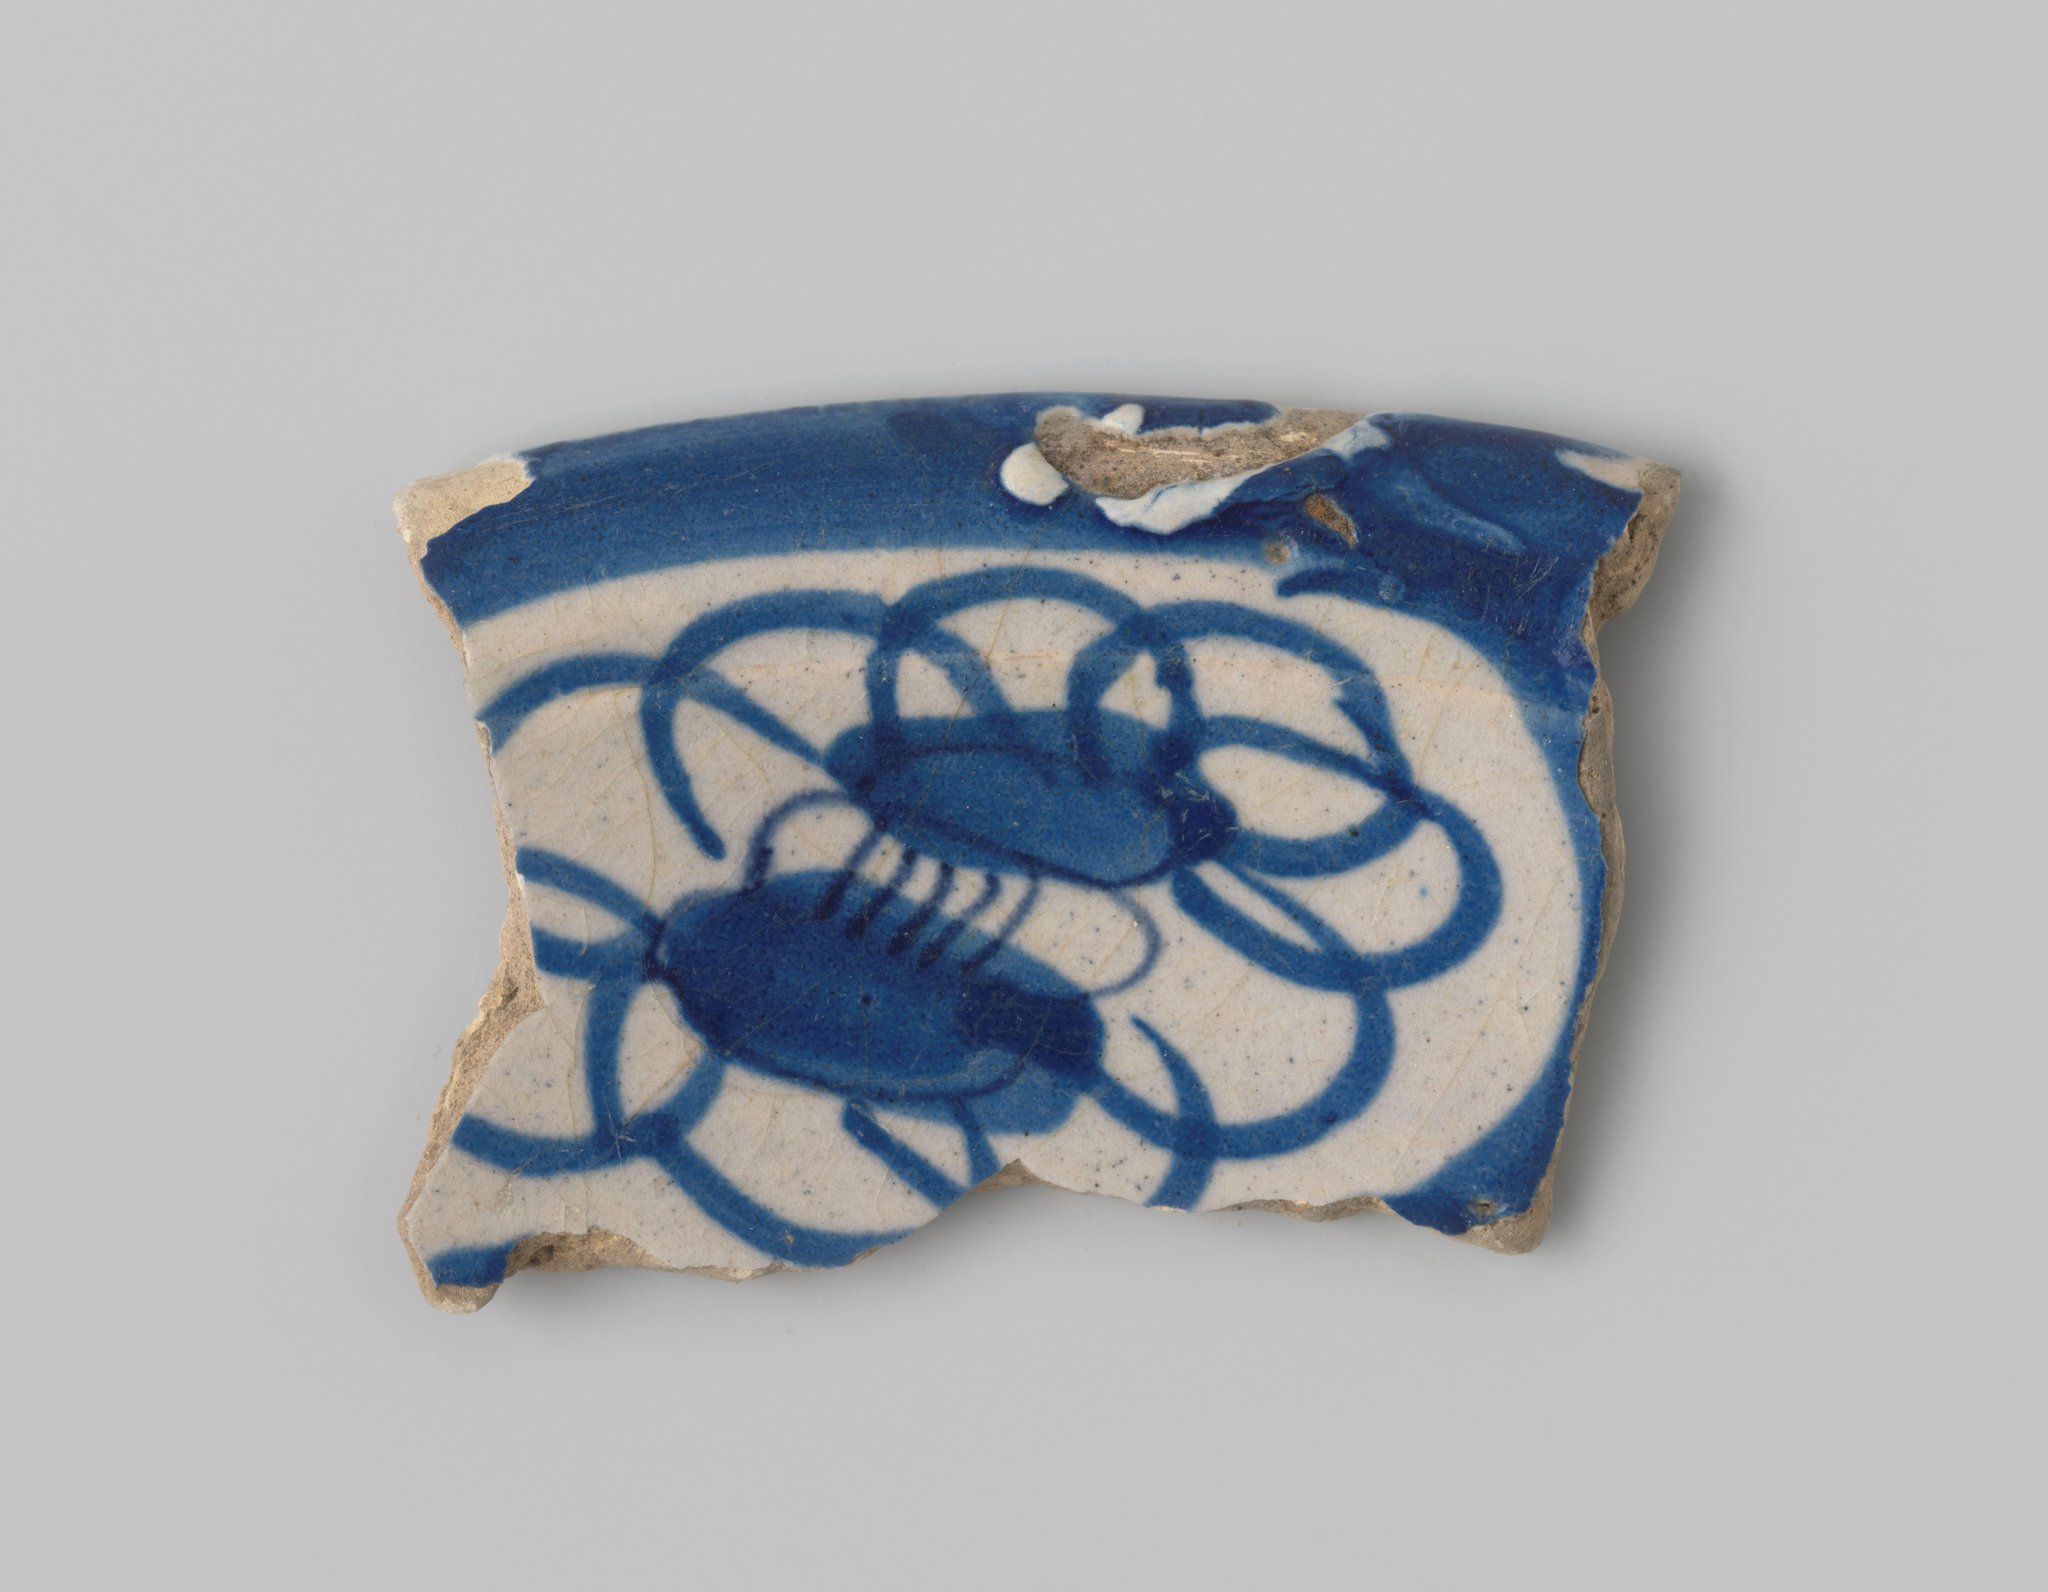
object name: sherd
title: Scherf van witbakkend aardewerk, aan de buitenzijde voorzien van een beschildering van bloemen in blauw op een witte ondergrond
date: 1500-1899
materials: earthenware, glaze